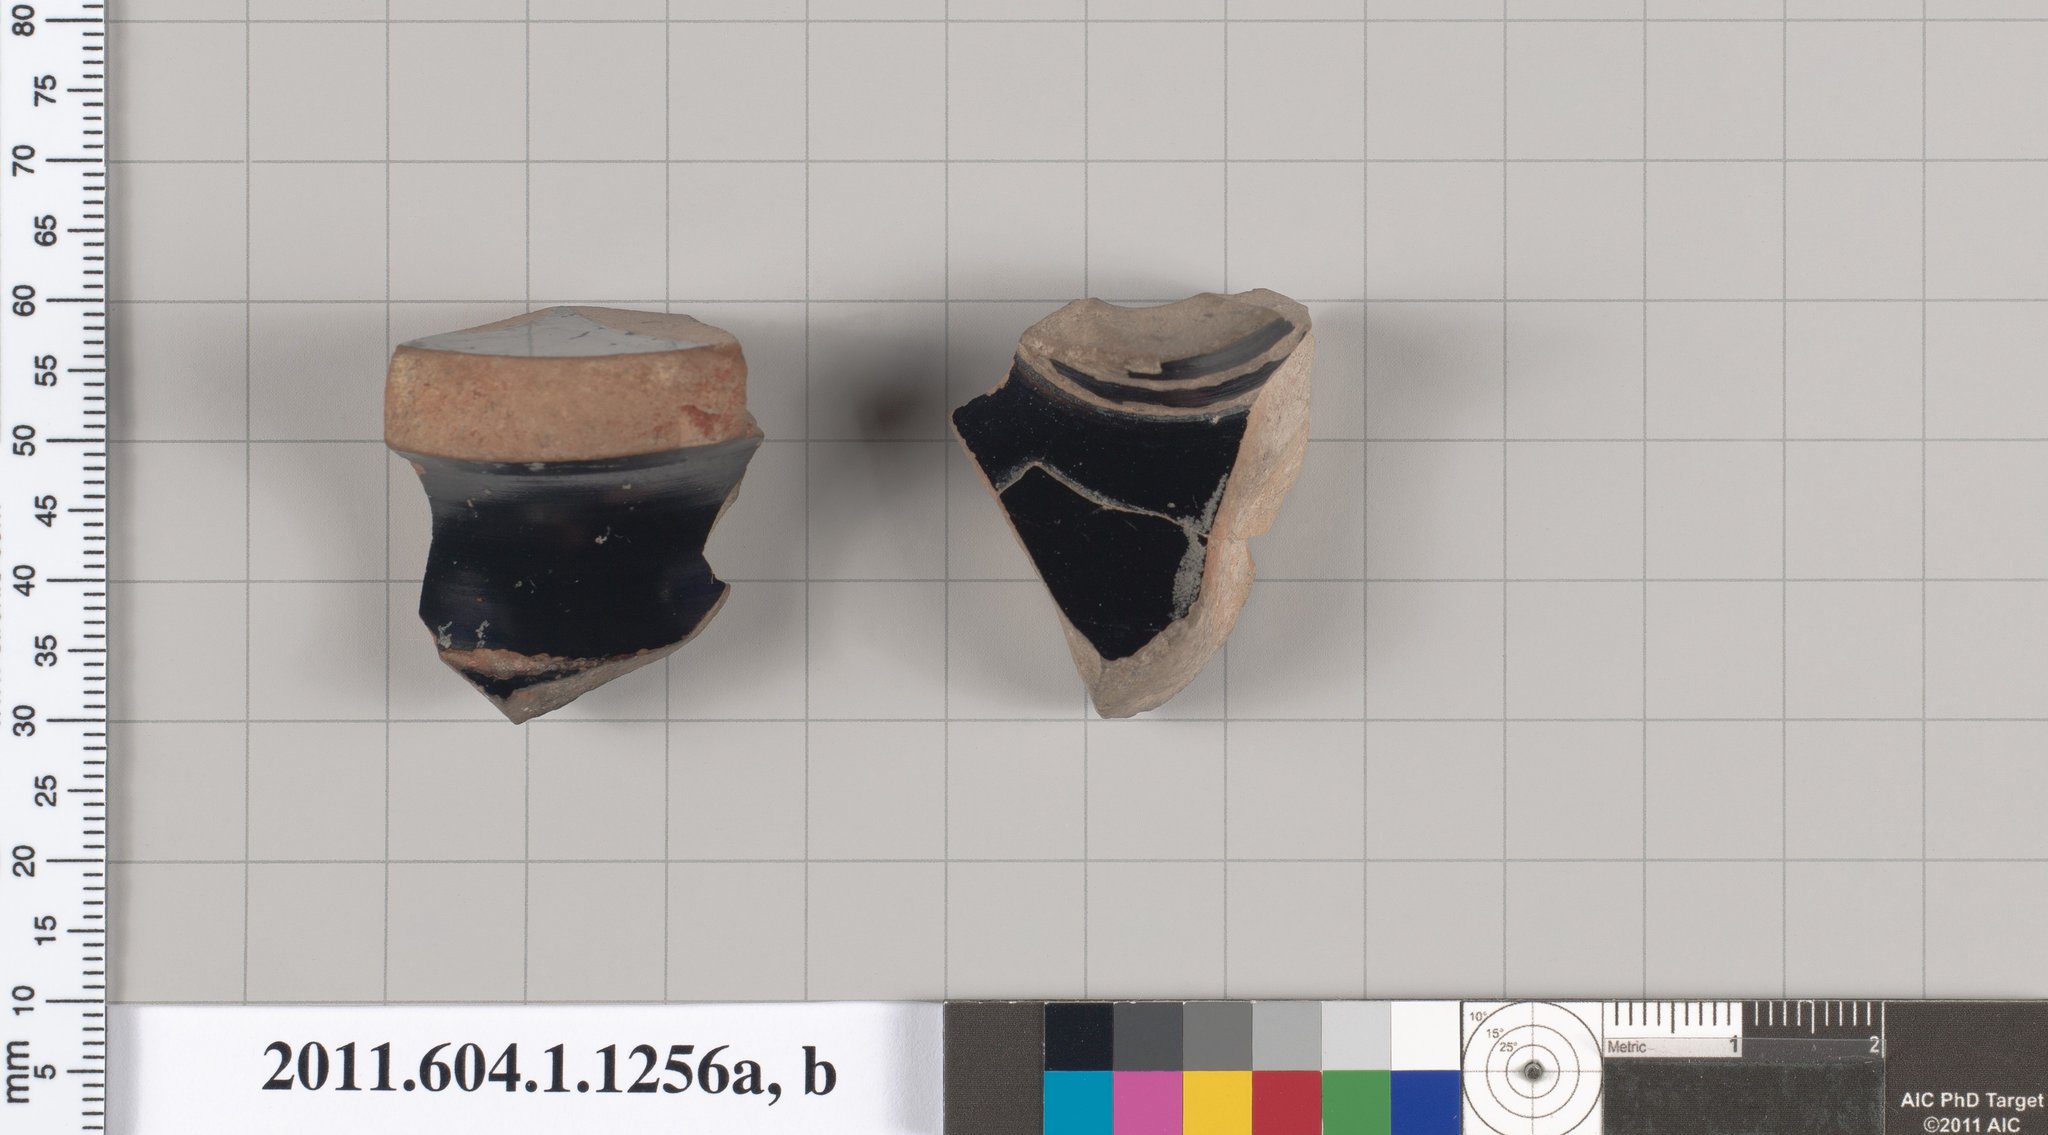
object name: kylix fragment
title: Terracotta fragments of kylikes (drinking cups)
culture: greek, attic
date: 500-401 BCE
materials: terracotta